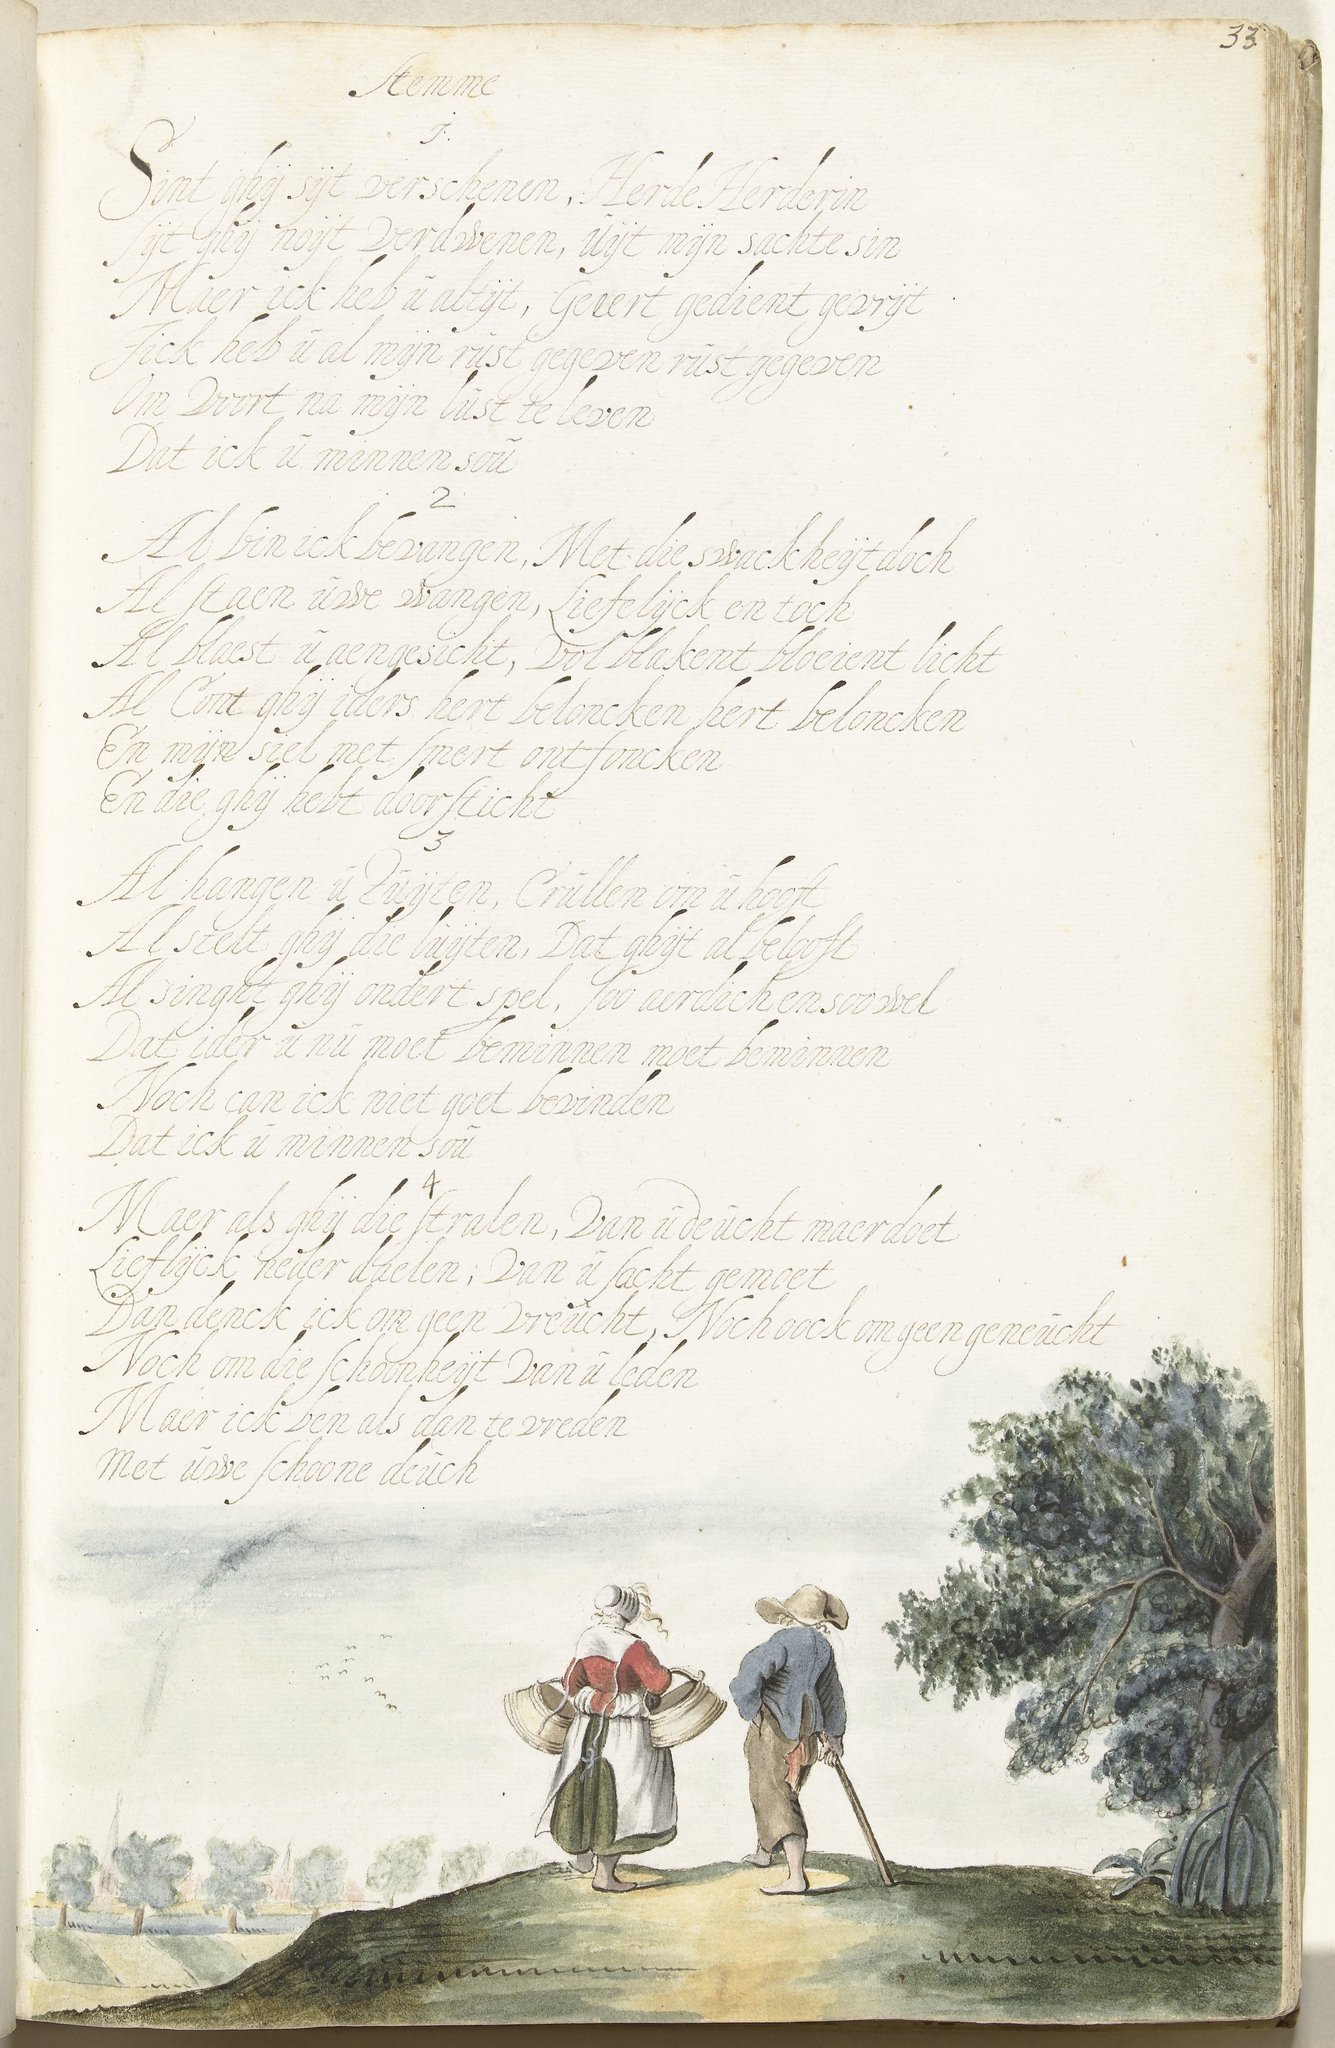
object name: calligraphy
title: Boerenpaar, van achteren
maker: gesina ter borch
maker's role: draughtsman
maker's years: 1633-1690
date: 1612-1653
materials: ink, paper, watercolor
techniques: brush, calligraphy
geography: zwolle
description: Boerenpaar in gesprek op een heuvel onder een gedicht met lofbetuigingen aan een vrouw, zonder aangegeven melodie.